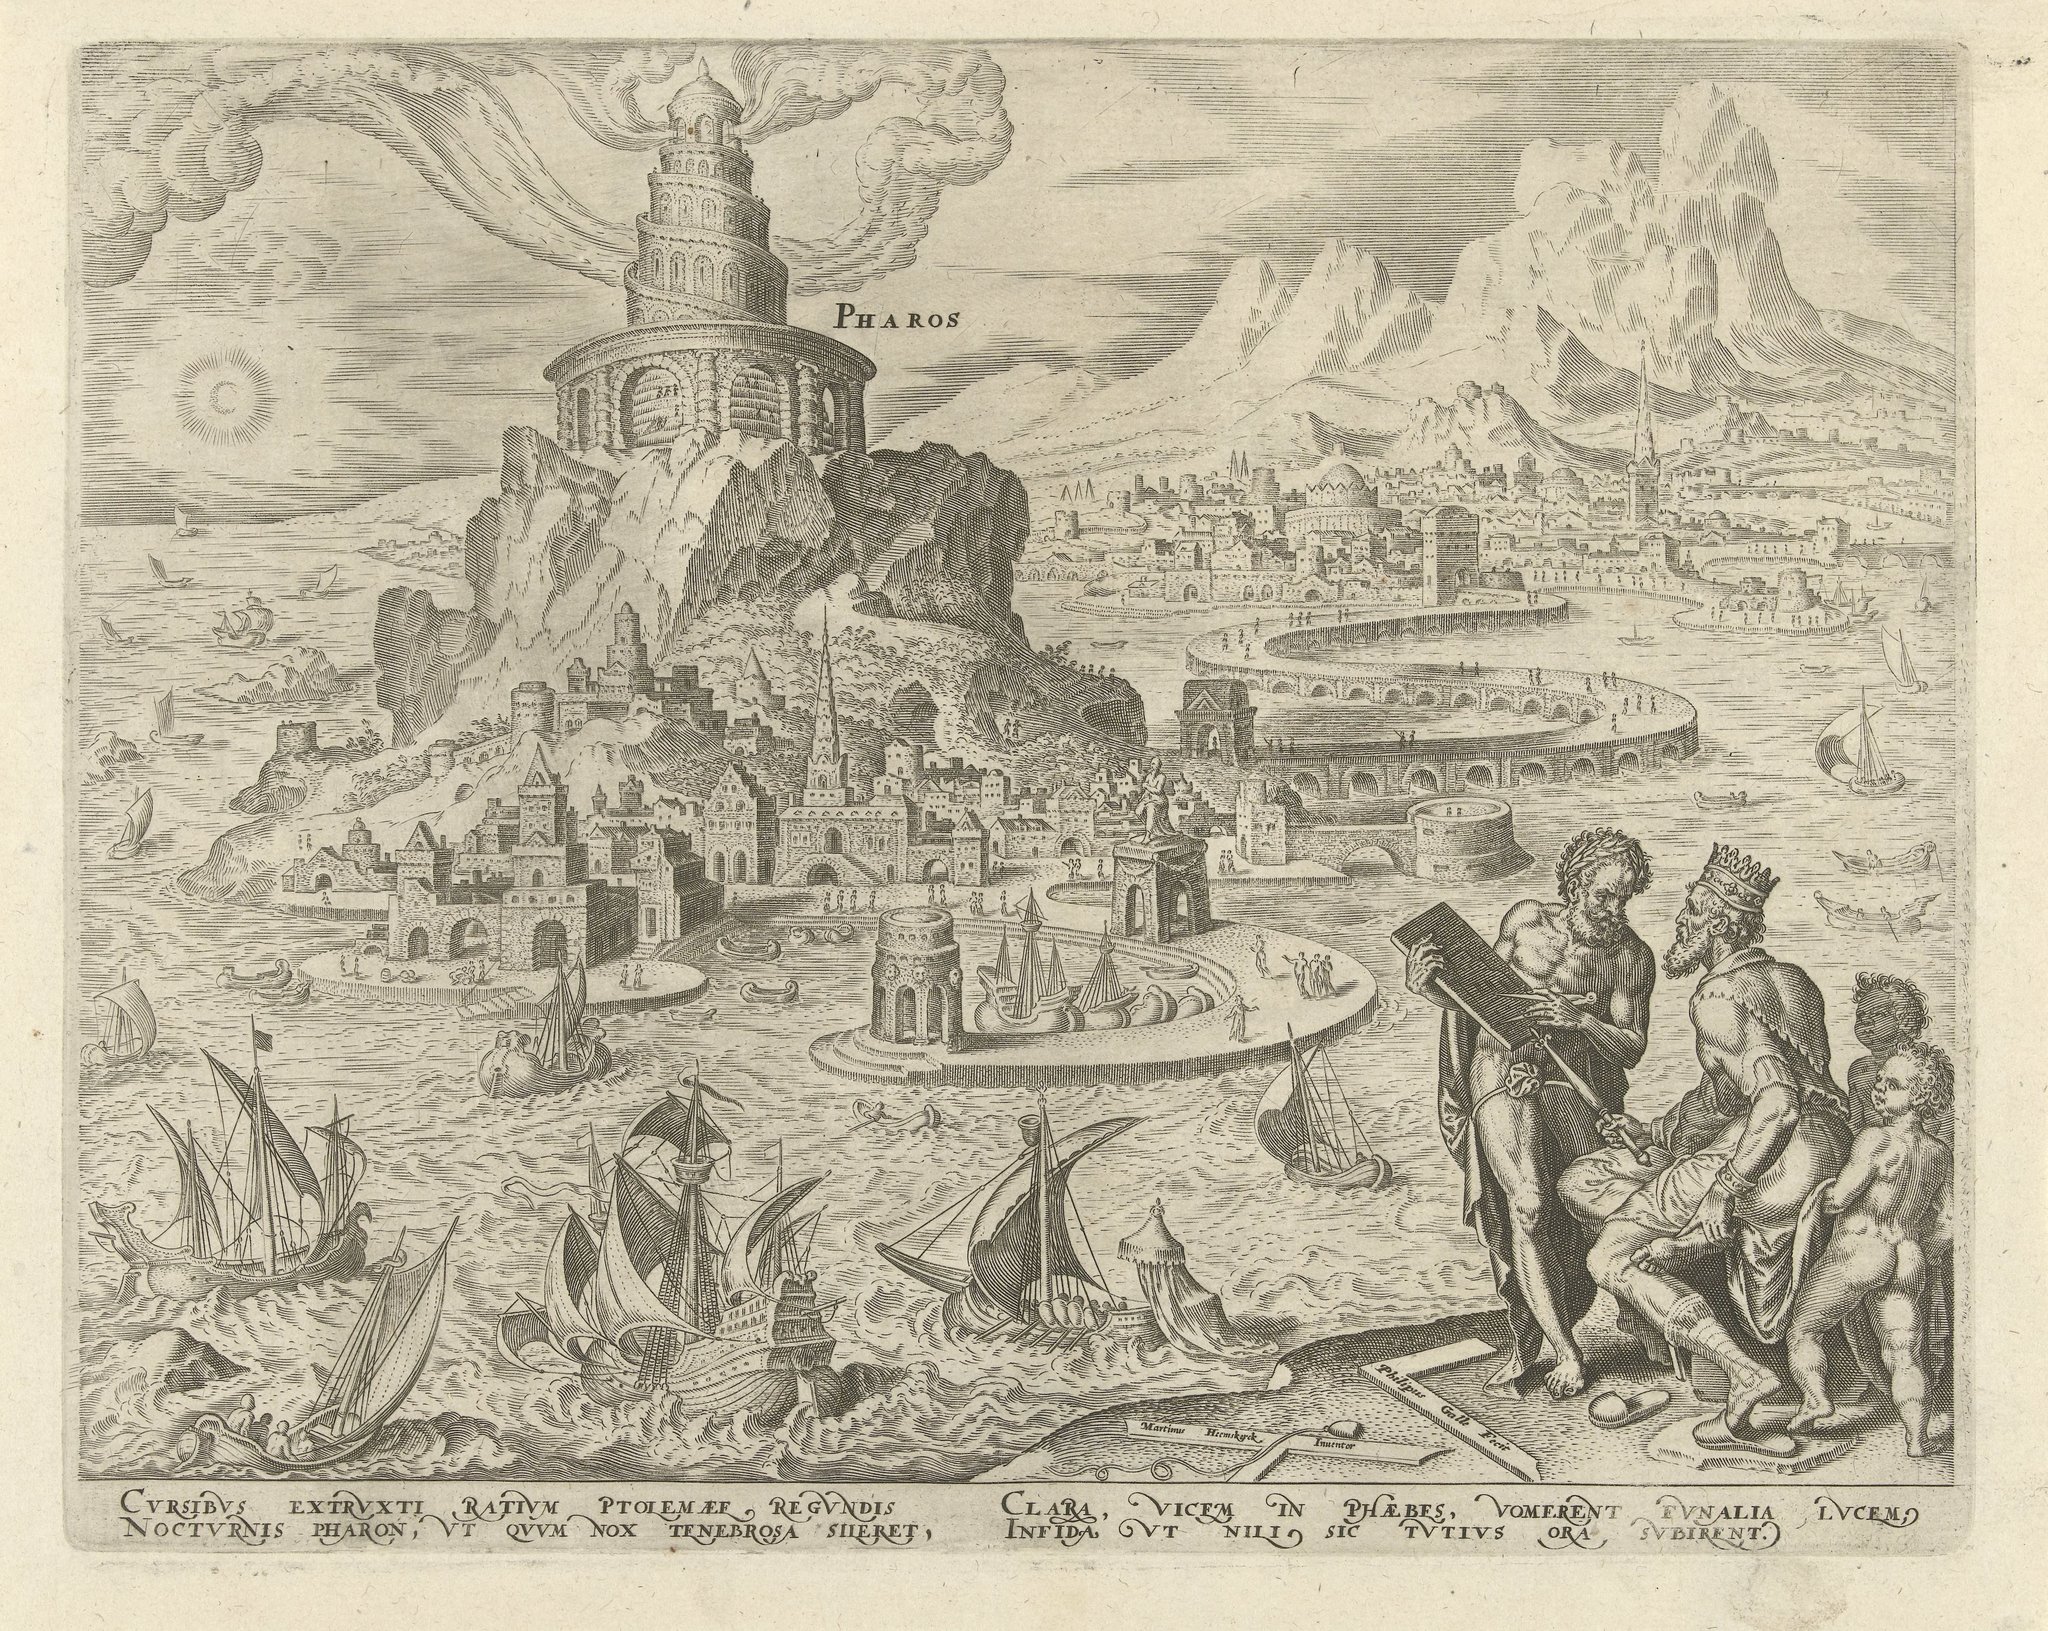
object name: print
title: Vuurtoren van Alexandrië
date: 1572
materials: paper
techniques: engraving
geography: antwerp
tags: lighthouse, lightship, island (in tropical and sub-tropical regions), non-aggressive activities of ptolemy philadelphus, pharos of alexandria (wonder of the world)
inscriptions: collector's mark: Lugt 2228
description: De vuurtoren van de stad Alexandrië. Voorzover bekend de eerste vuurtoren die ooit werd gebouwd. Dit gebeurde in opdracht van de eerste hellenistische koning van Egypte Ptolemaeus II. De toren werd tussen 297 en 283 v. Chr. gebouwd en heeft bijna 1500 jaar dienst gedaan voor achtereenvolgens de Grieken, Romeinen, Byzantijnen en Arabieren. Hij stond op het eiland Pharos in de Middellandse Zee, net buiten de haven van het Egyptische Alexandrië. In de voorgrond rechts Ptolemaeus II en de architect van de vuurtoren, Sostratus van Knidos. De prent heeft een Latijns onderschrift en maakt deel uit van een serie over de acht wereldwonderen.